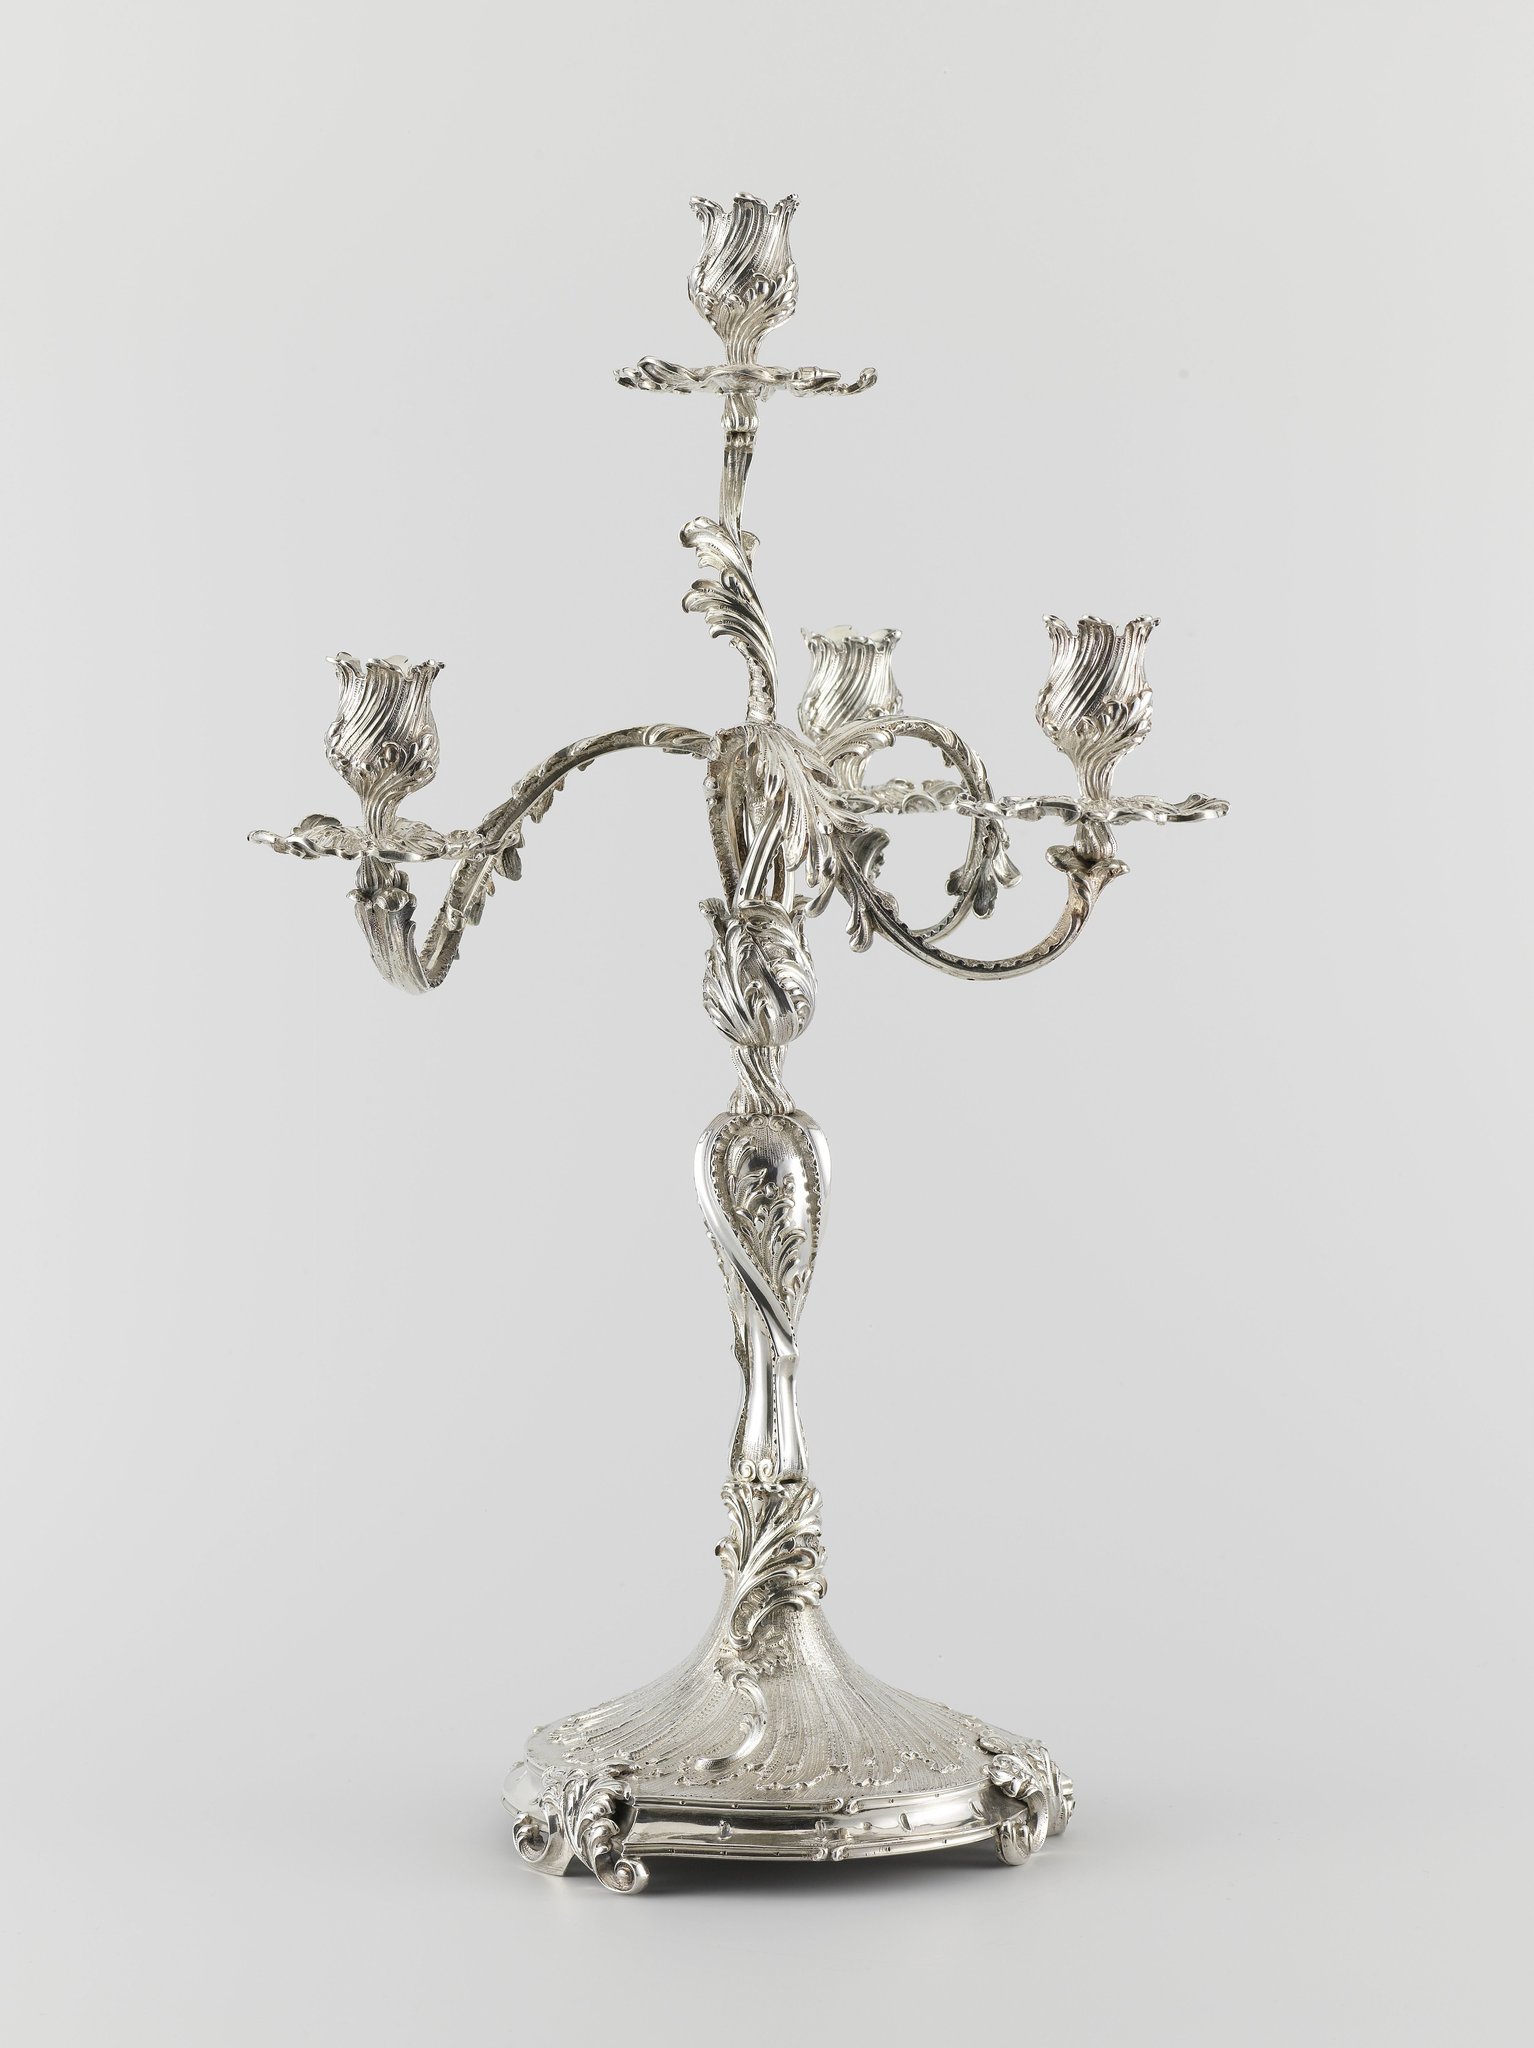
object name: candelabrum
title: Two candelabra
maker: karel sluijterman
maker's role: designer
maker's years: 1863-1931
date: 1891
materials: silver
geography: amsterdam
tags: ornament derived from plant forms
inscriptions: maker's mark, assayer's mark, assay office mark, alloy mark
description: Kandelaber van zilver, deel van een ensemble.